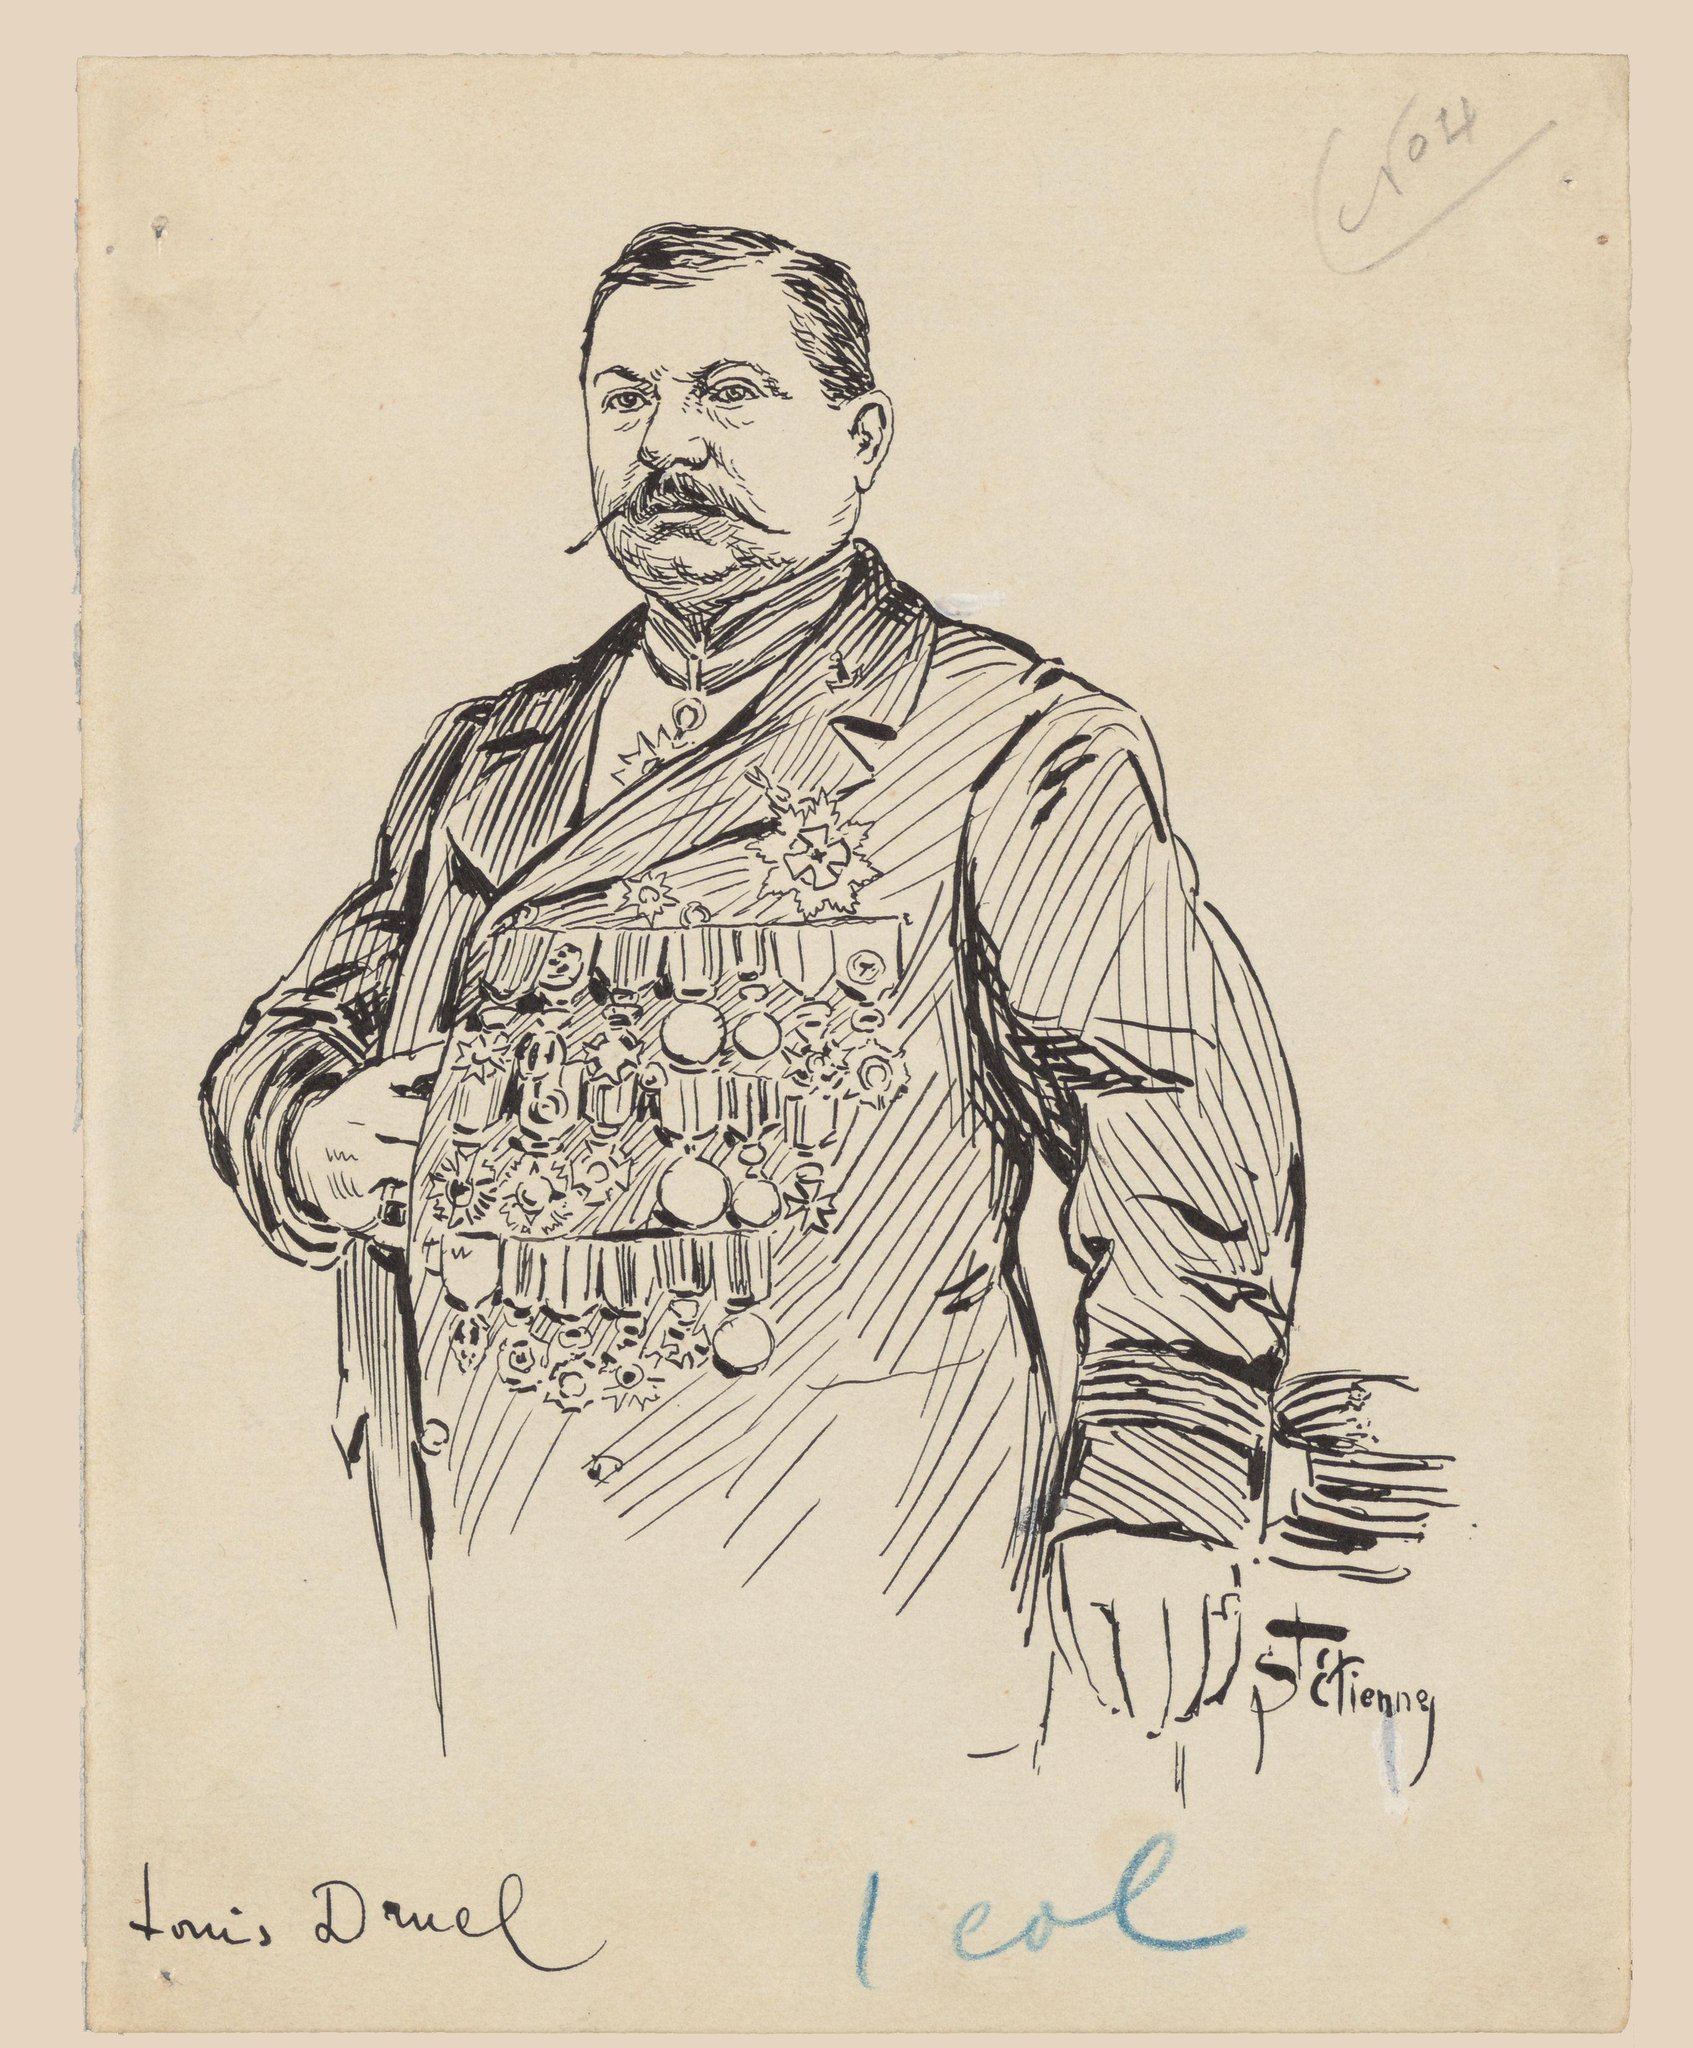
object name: drawing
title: Portret van Louis Druel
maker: Anonymous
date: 1900-1949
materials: ink, paper, pencil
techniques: pen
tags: chairman, knighthood order, historical persons